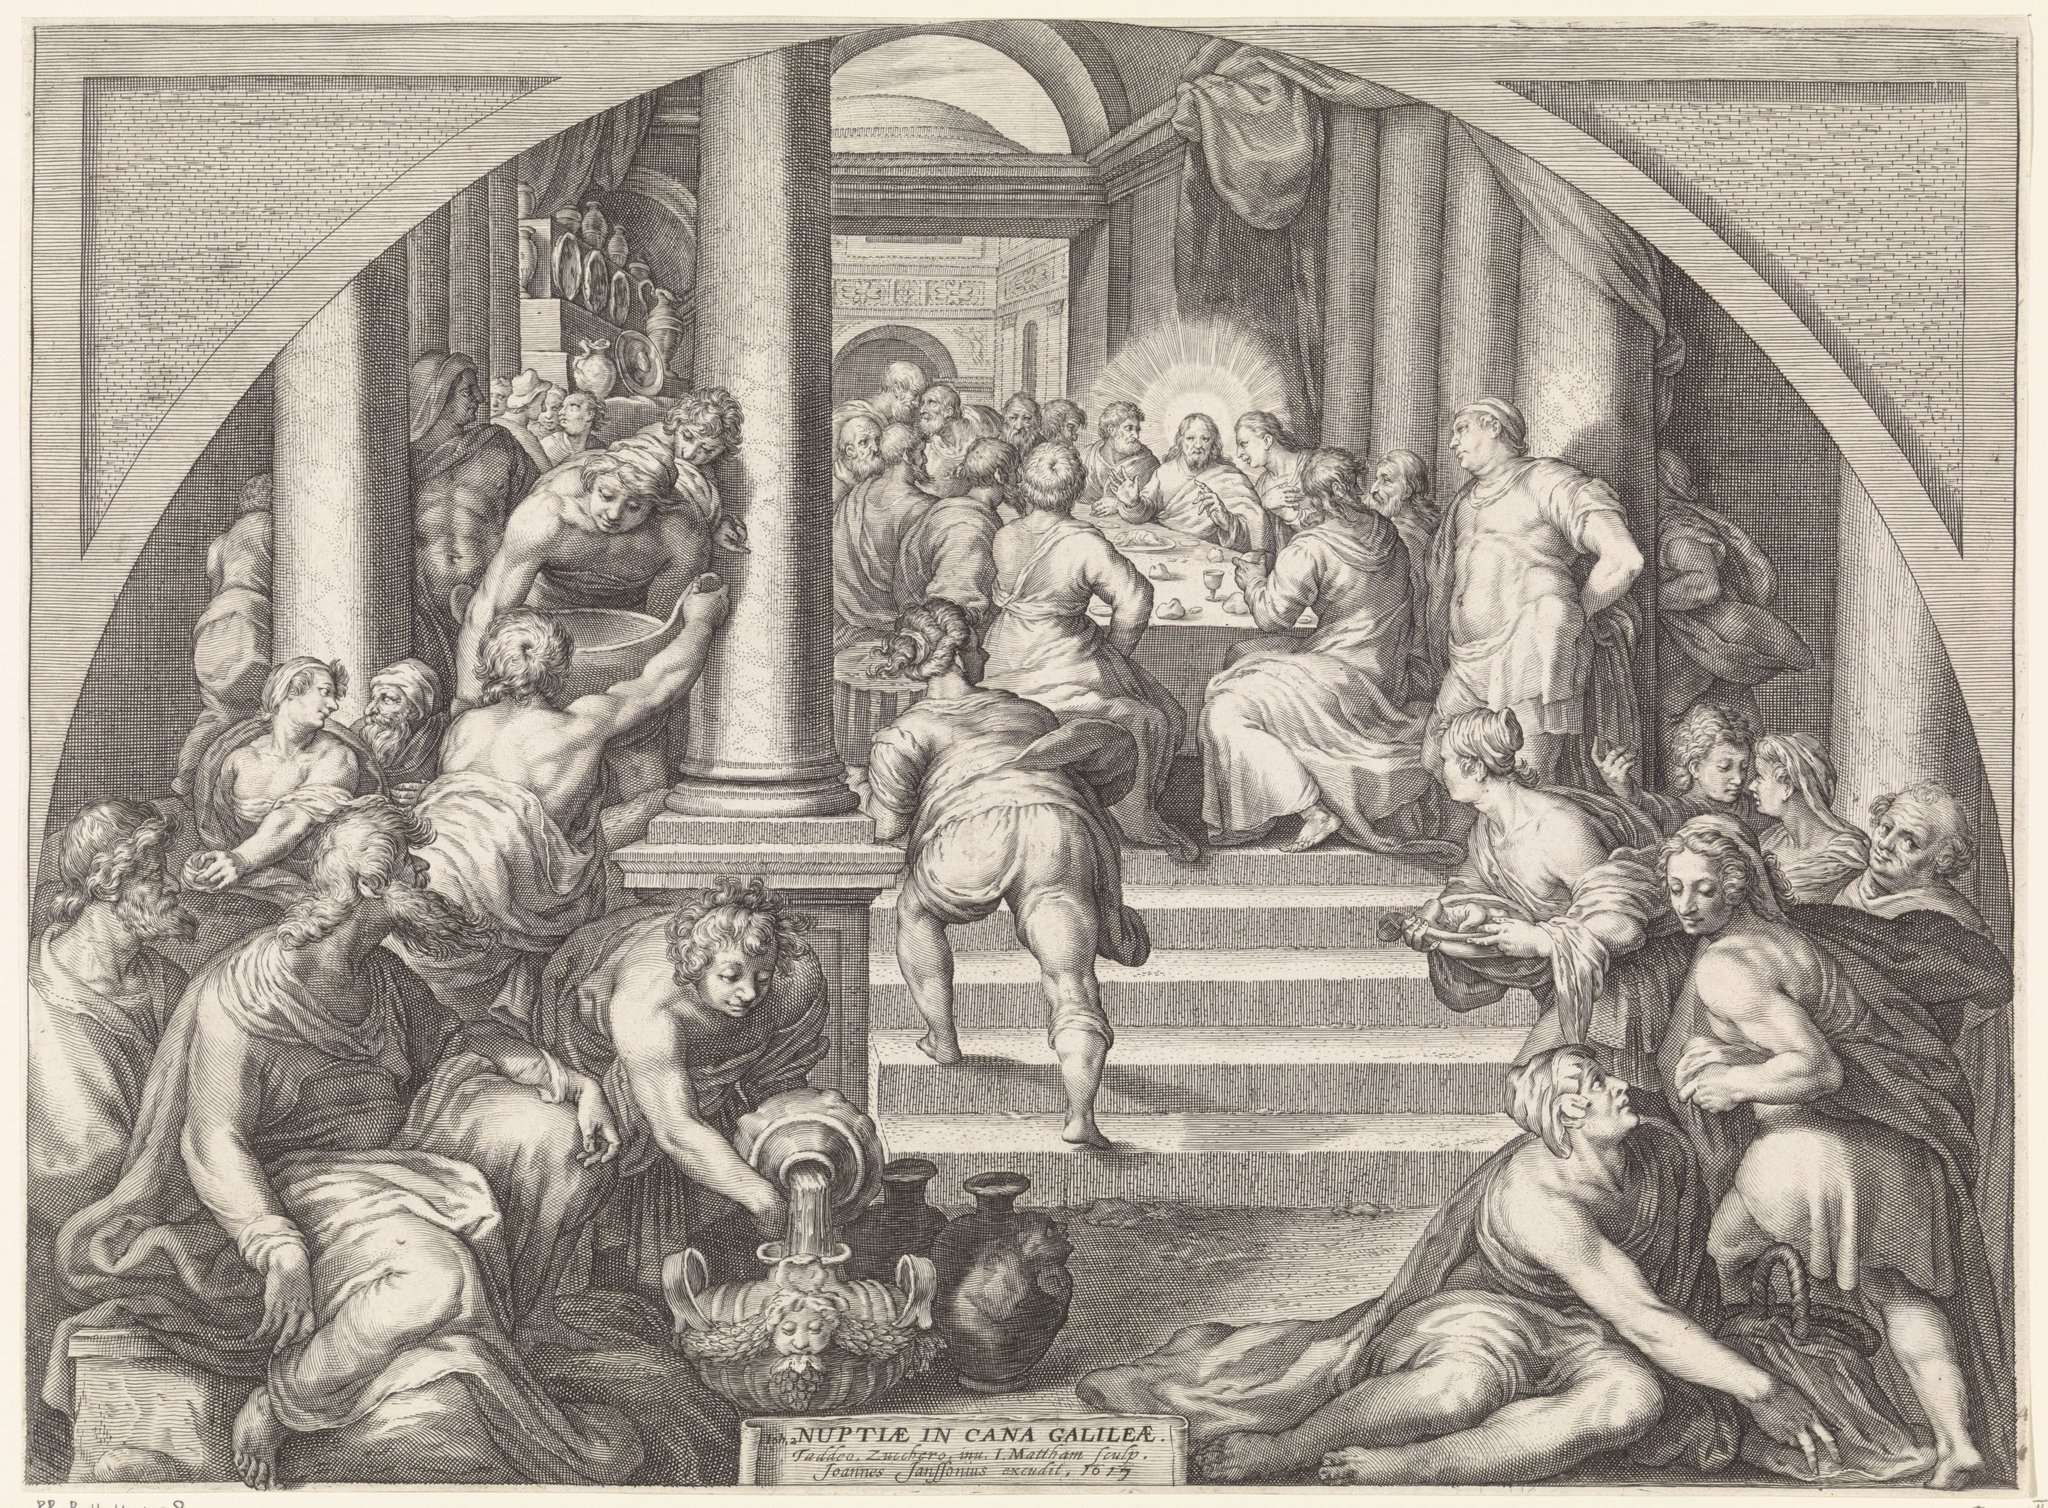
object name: print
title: Nuptiae in Canna Galileae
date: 1617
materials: paper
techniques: engraving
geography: amsterdam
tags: the marriage-feast at cana (john 2:1-11)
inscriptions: collector's mark: Lugt 10, collector's mark: Lugt 11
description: Christus aan tafel tijdens de bruiloft te Kana. Op de voorgrond worden spijzen en dranken door bediendes aangereikt.